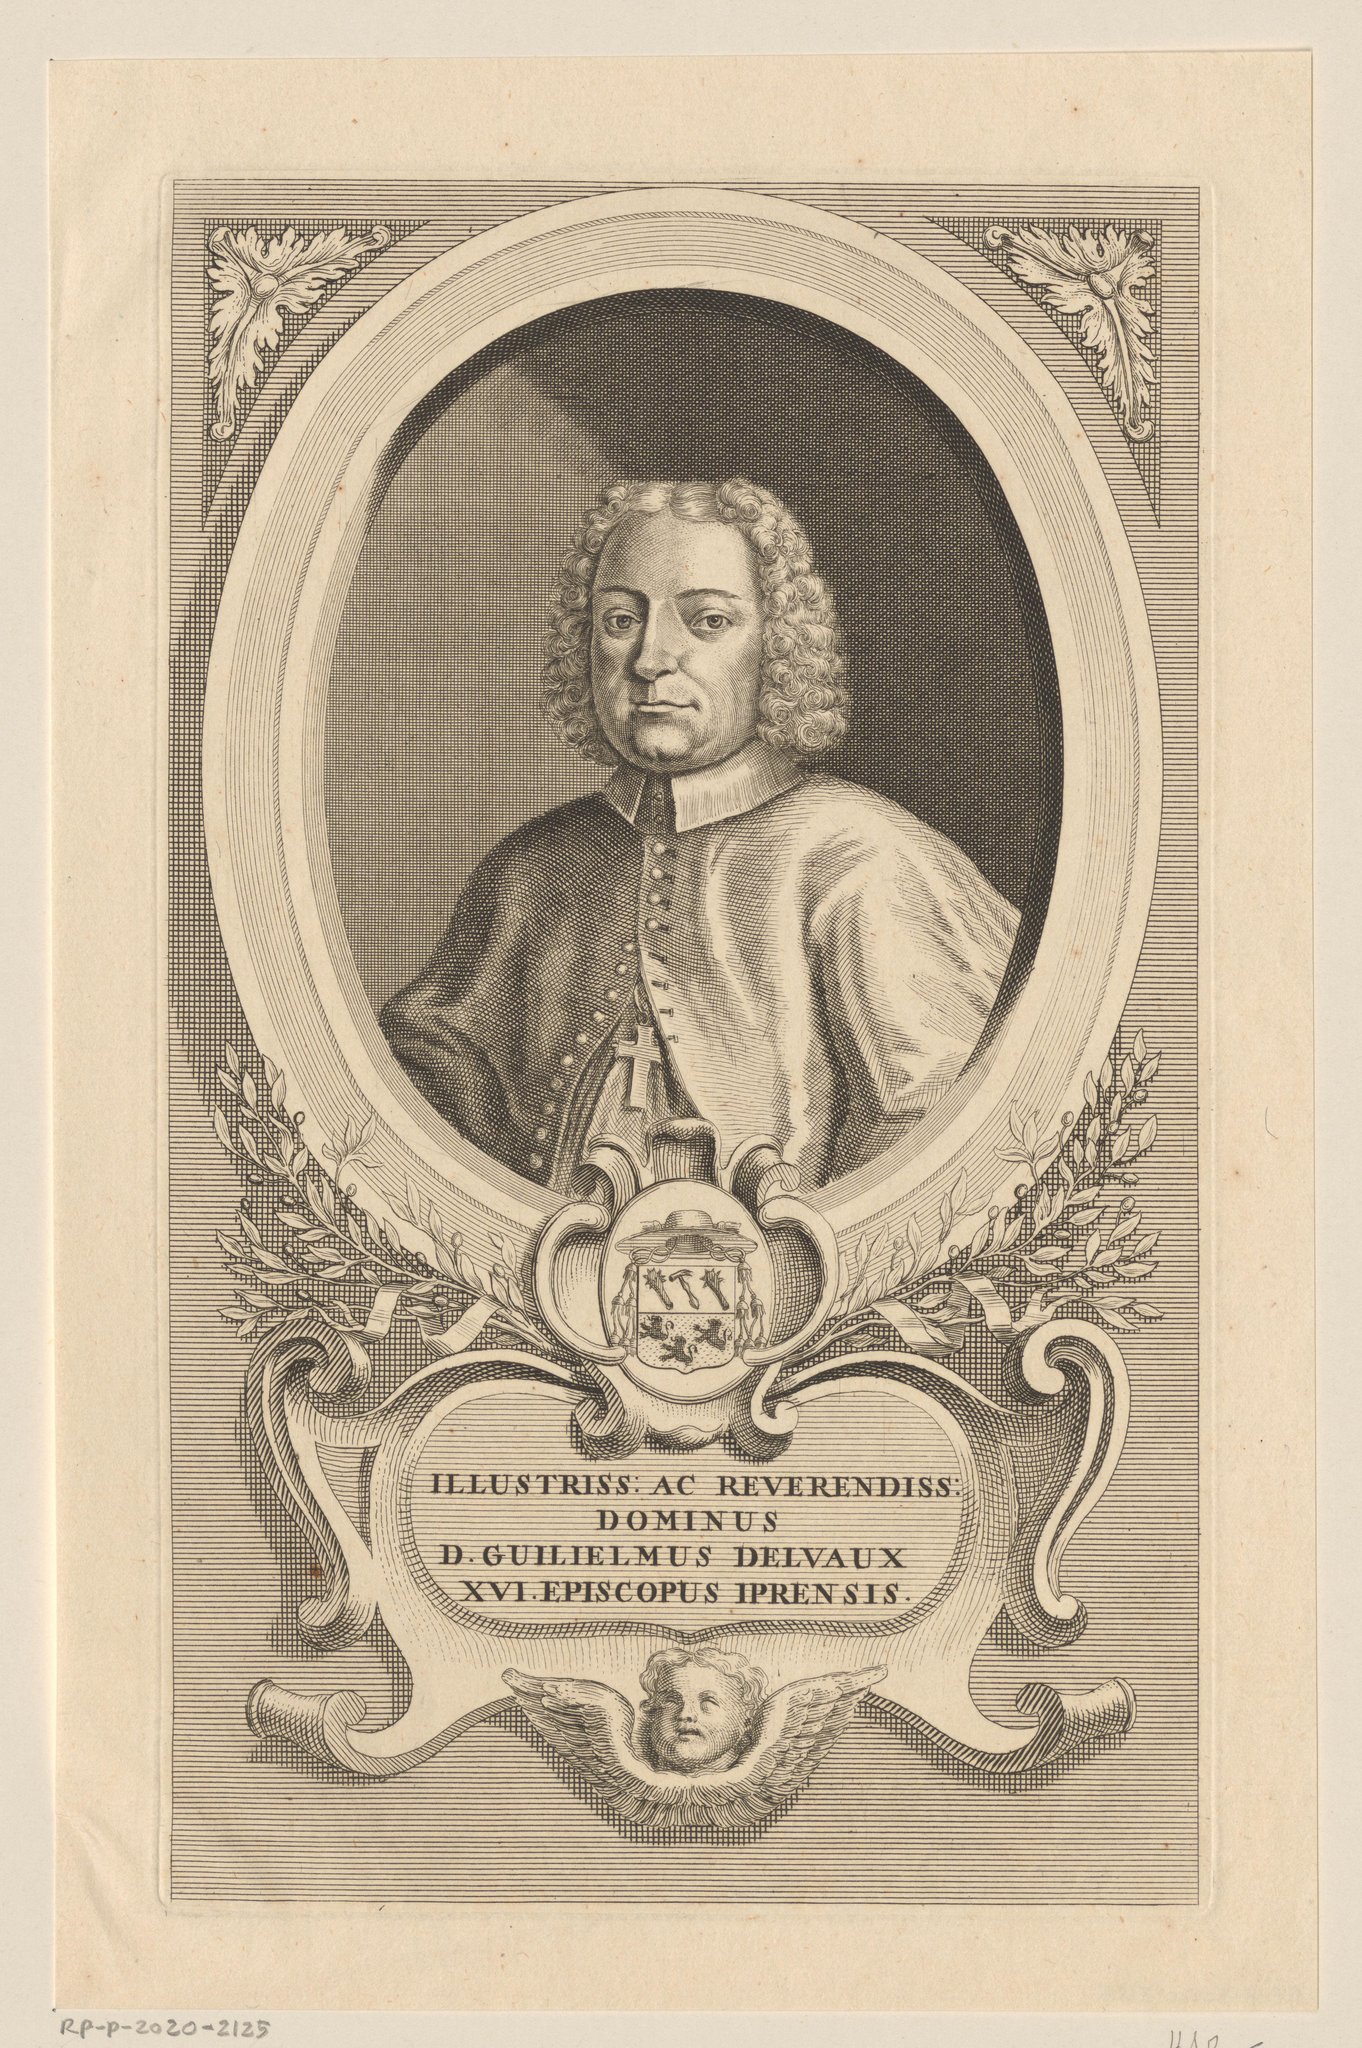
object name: print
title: Portret van Guillaume Delvaux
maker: Anonymous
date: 1735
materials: paper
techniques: engraving, etching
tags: archbishop, bishop, etc. (roman catholic), historical persons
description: Prent mogelijk uit: Sanderus, Antonius. Flandria illustrata sive provinciae ac comitatus (...). 3 dln. Brussel: Carolus de Vos en Joannes Baptista de Vos, 1735.